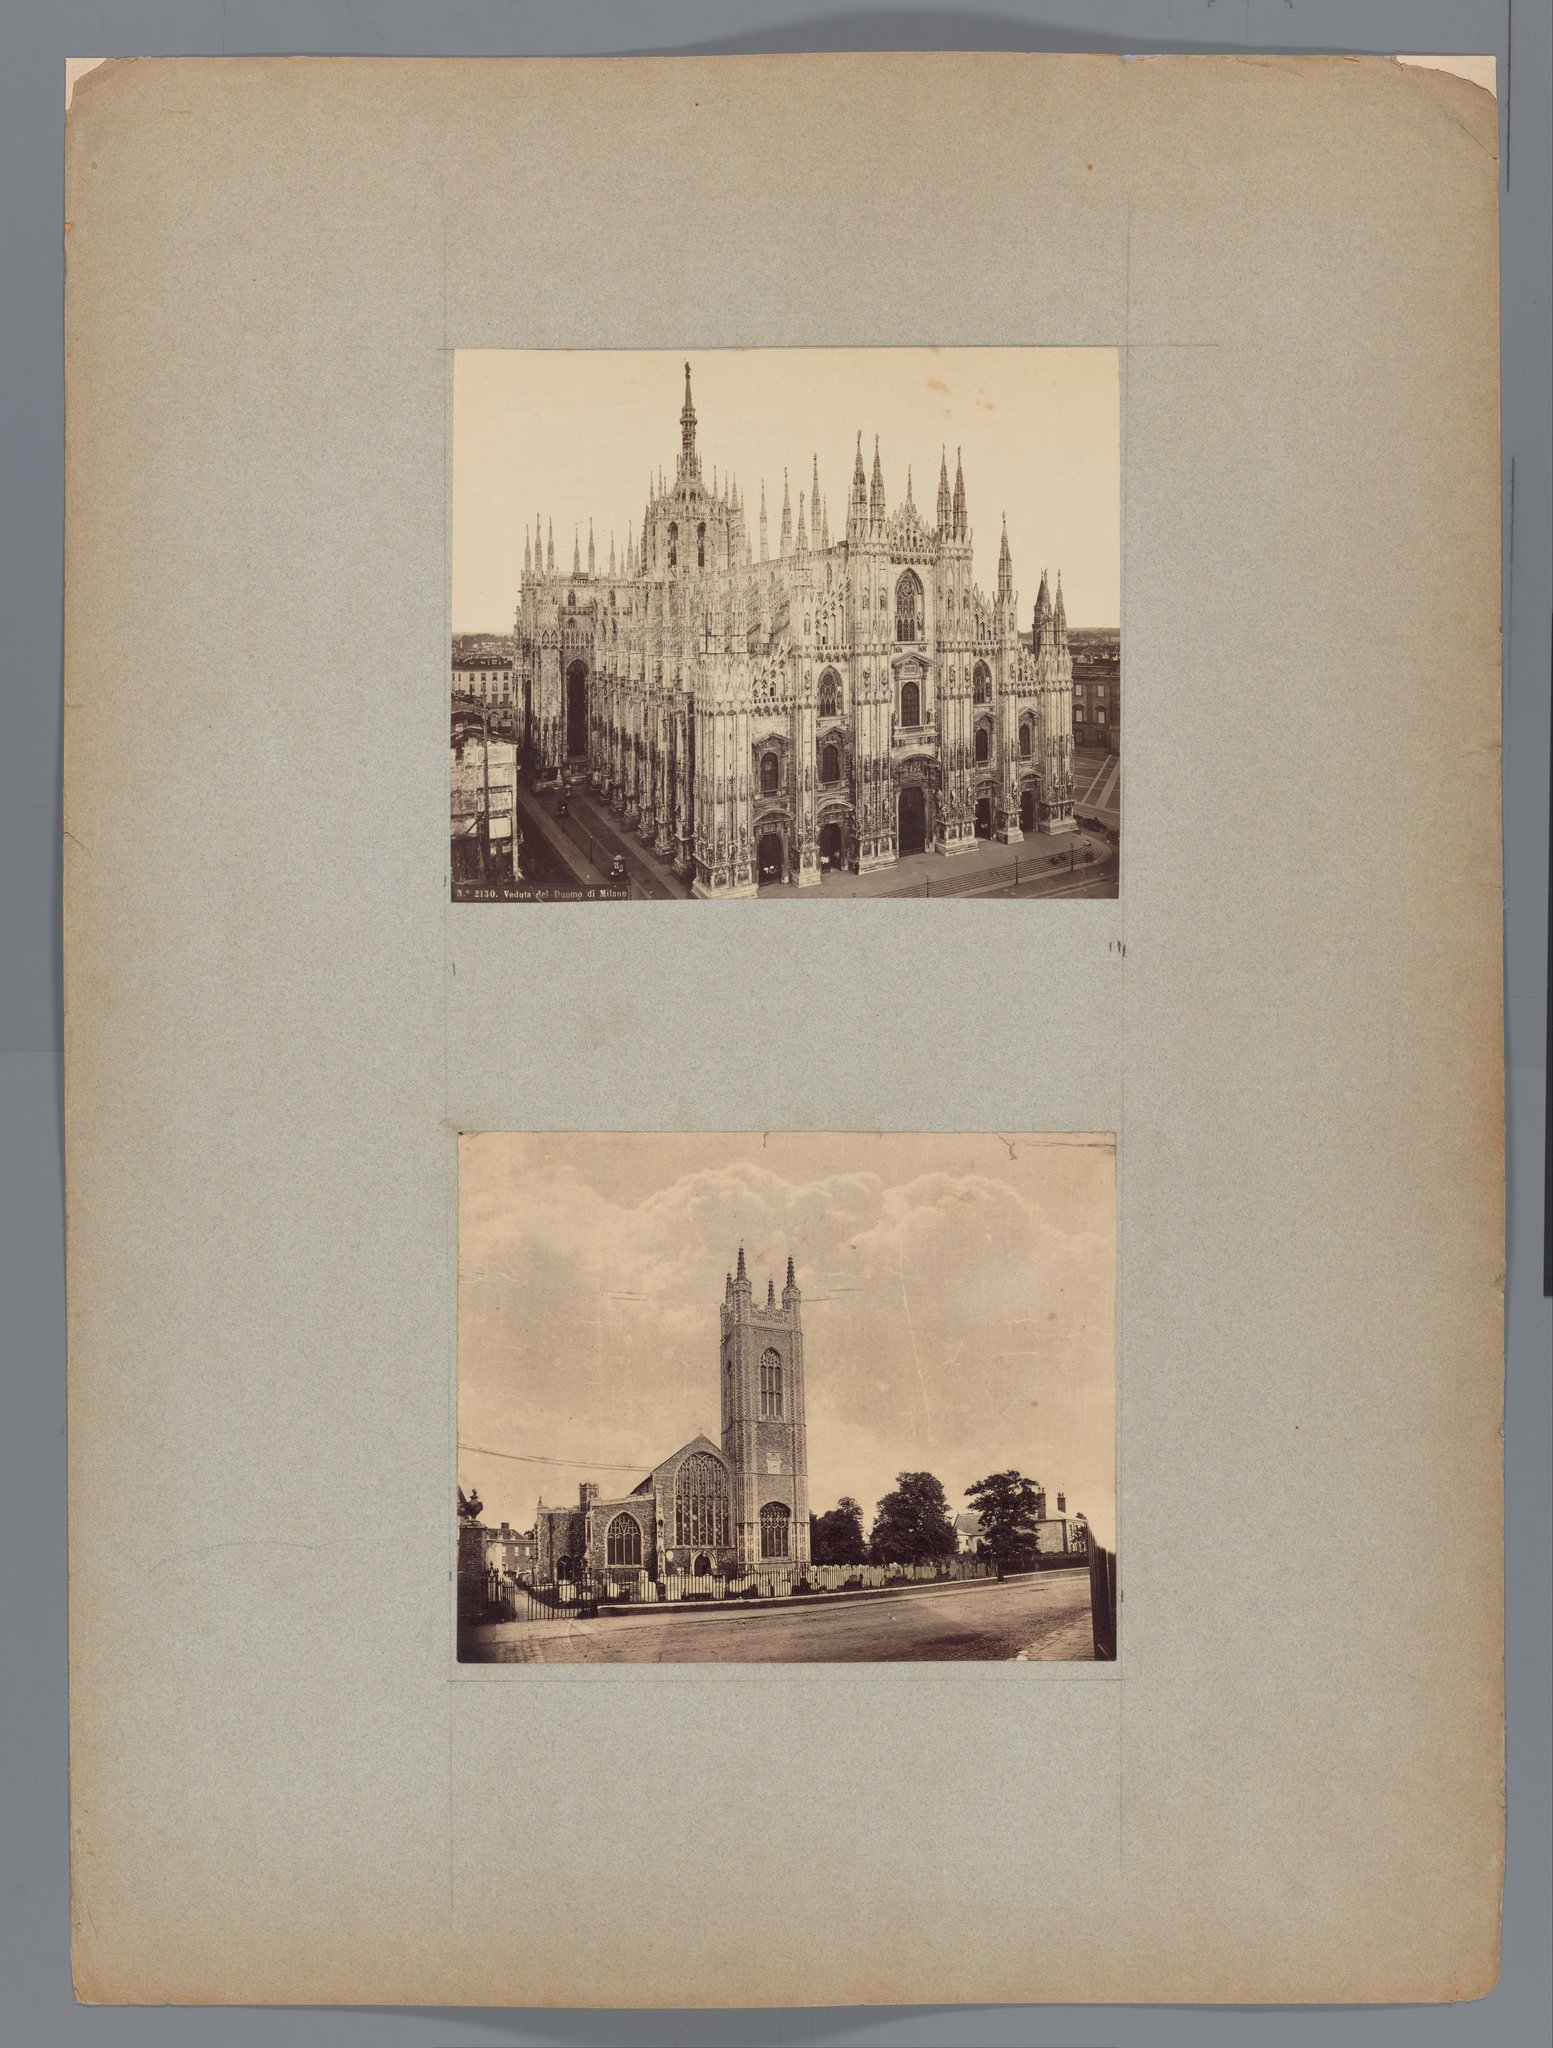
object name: photograph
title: Gezicht op de Dom te Milaan, noordwestzijde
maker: roberto rive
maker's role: fotograaf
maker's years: 1825-1868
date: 1865-1900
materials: cardboard, photographic support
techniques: albumen print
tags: dom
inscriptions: : ‘No. 2130. Veduta del Duomo di Milano’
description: Foto zit samen met RP-F-2006-18-32-2 op één blad geplakt.